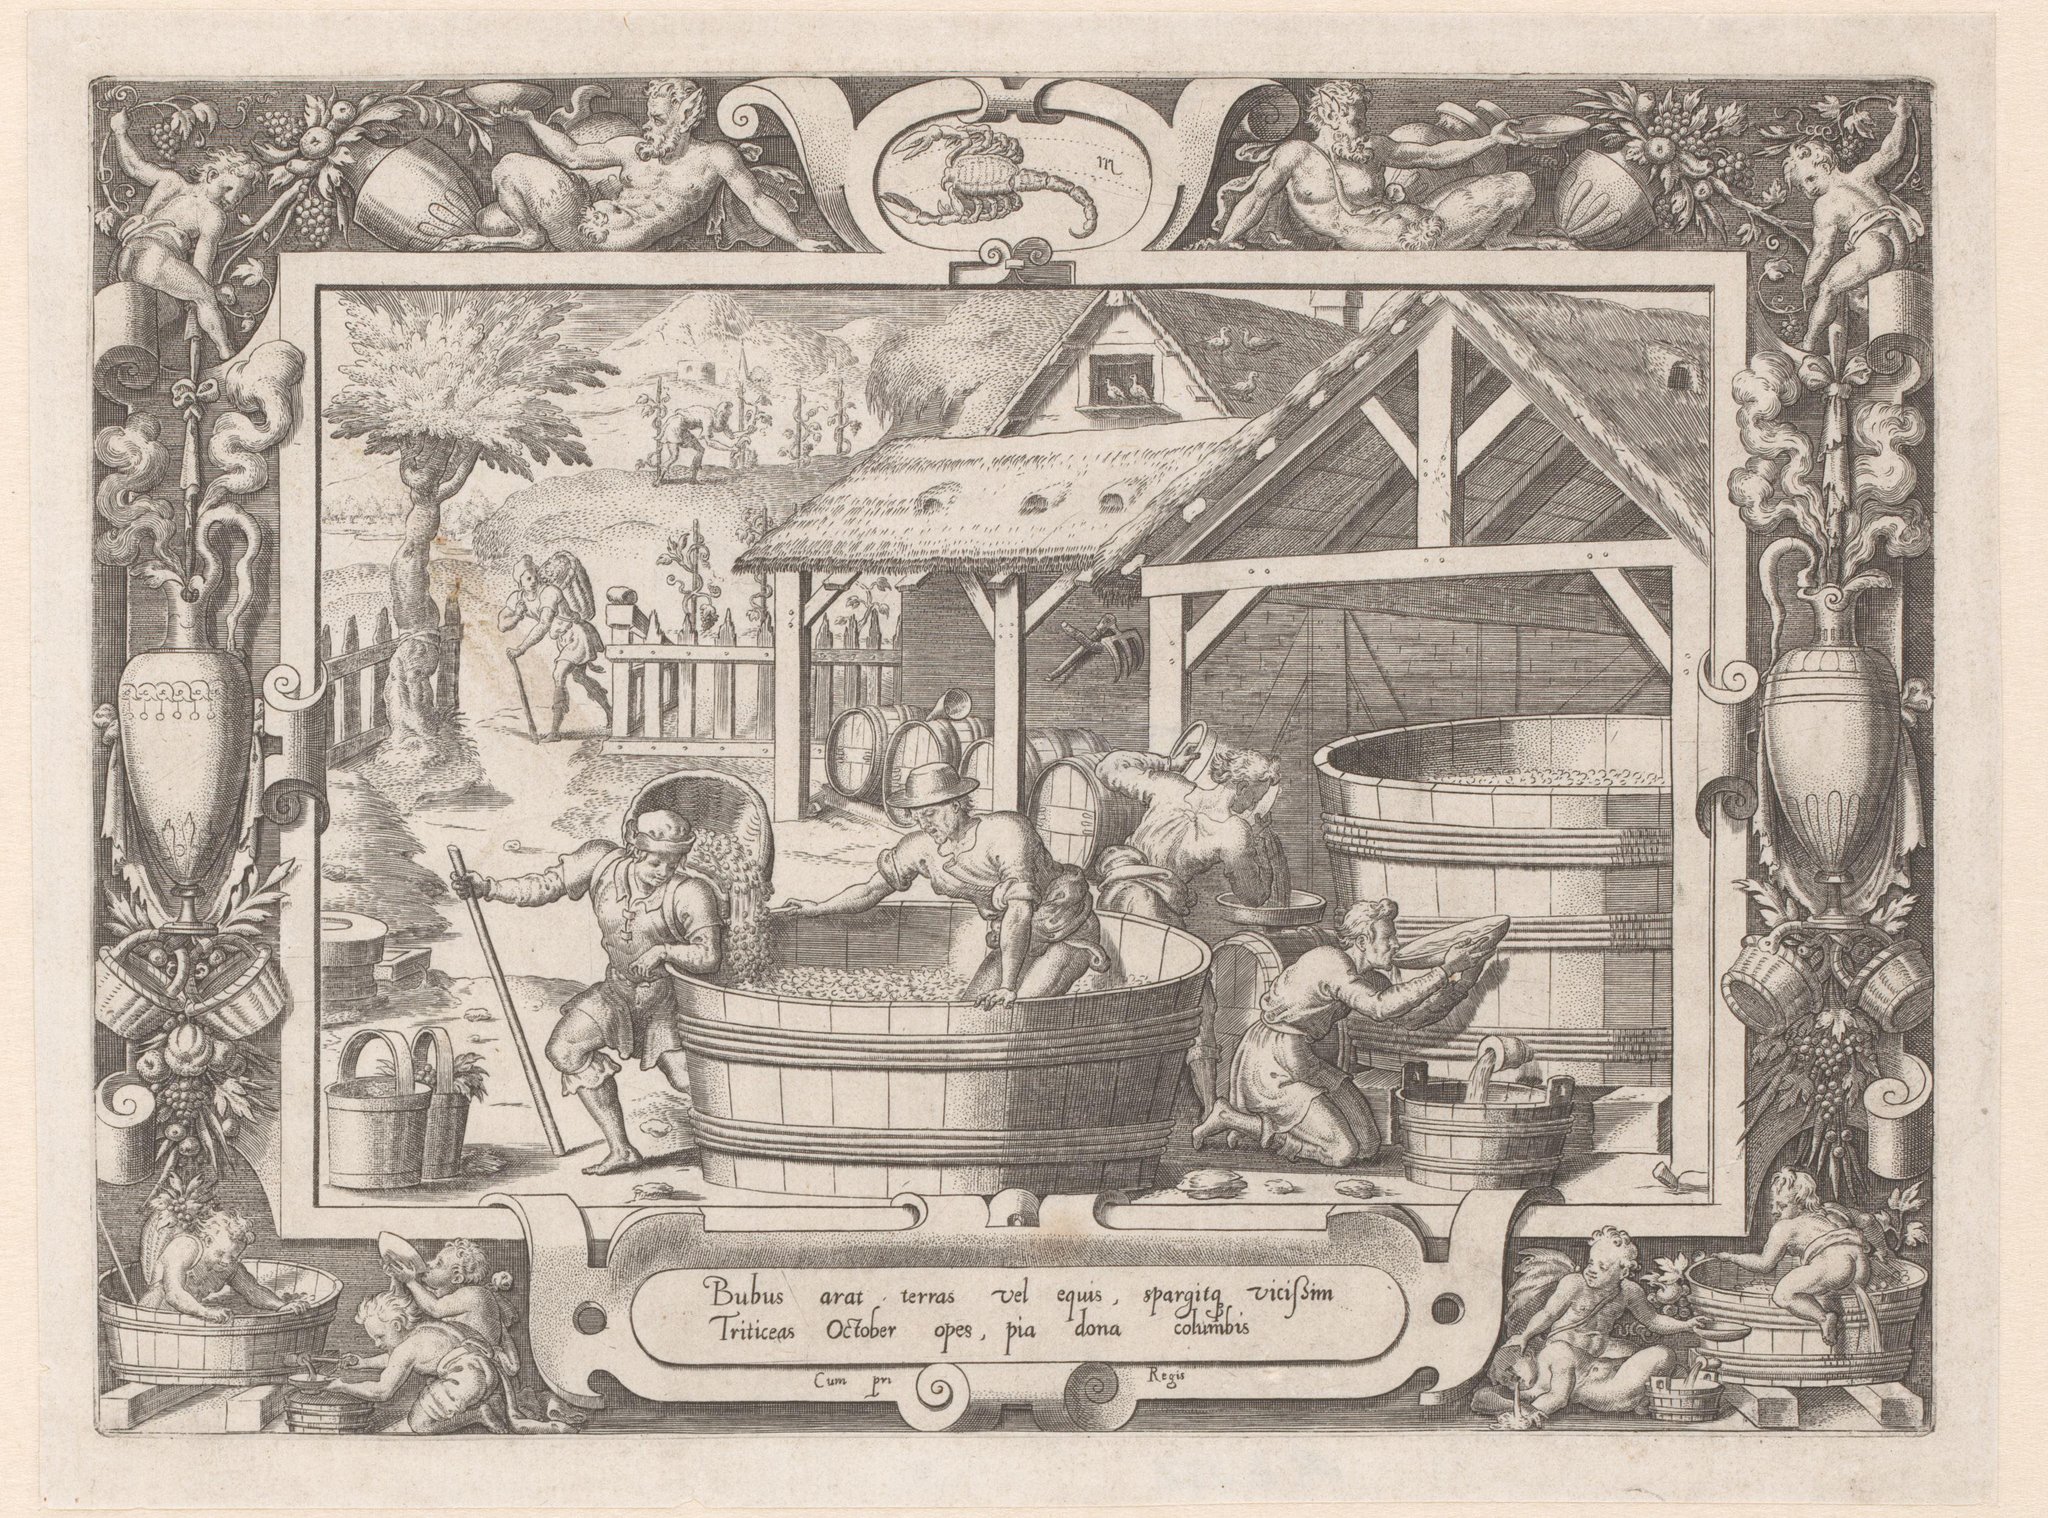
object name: print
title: Twaalf maanden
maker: etienne delaune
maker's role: draughtsman, goldsmith, print maker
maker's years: 1519-1583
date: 1566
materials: paper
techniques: engraving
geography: france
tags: wine production, scorpio (zodiacal sign of october), october and its 'labours' (+ with zodiacal signs)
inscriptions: collector's mark: Lugt 2228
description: Maakt deel uit van een twaalfdelige serie van de twaalf maanden in ornamentele lijsten met corresponderende motieven en tekens van de dierenriem. Januari, met het hoofd van Janus, vormt de enige uitzondering. In de collectie van het Rijksmuseum bevindt zich de complete serie.